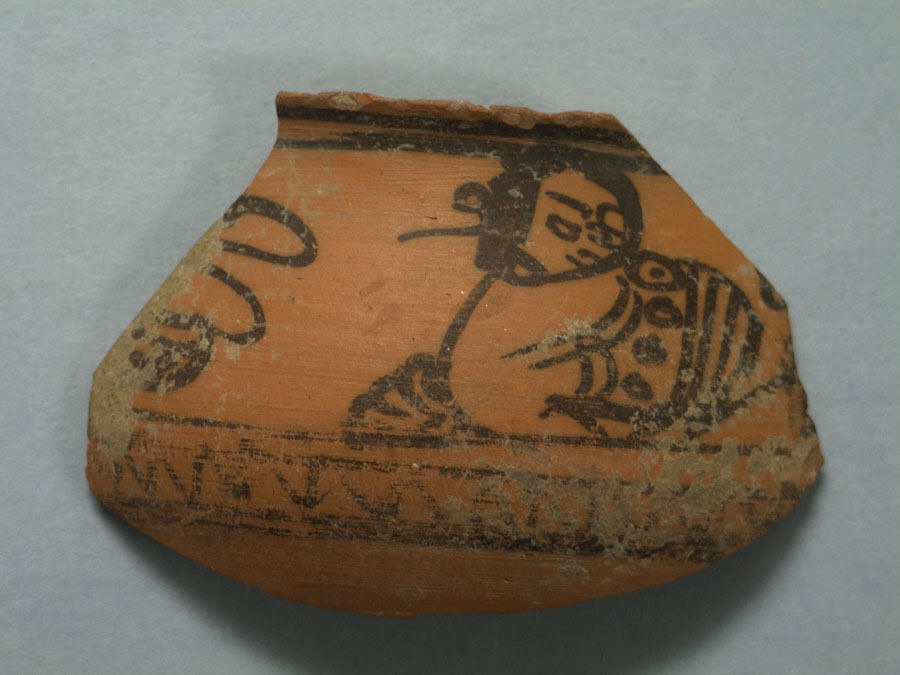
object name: shard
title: Shard: Profile of Offerer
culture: pakistani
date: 301-500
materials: terracotta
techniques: painting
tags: human figures,gandhara